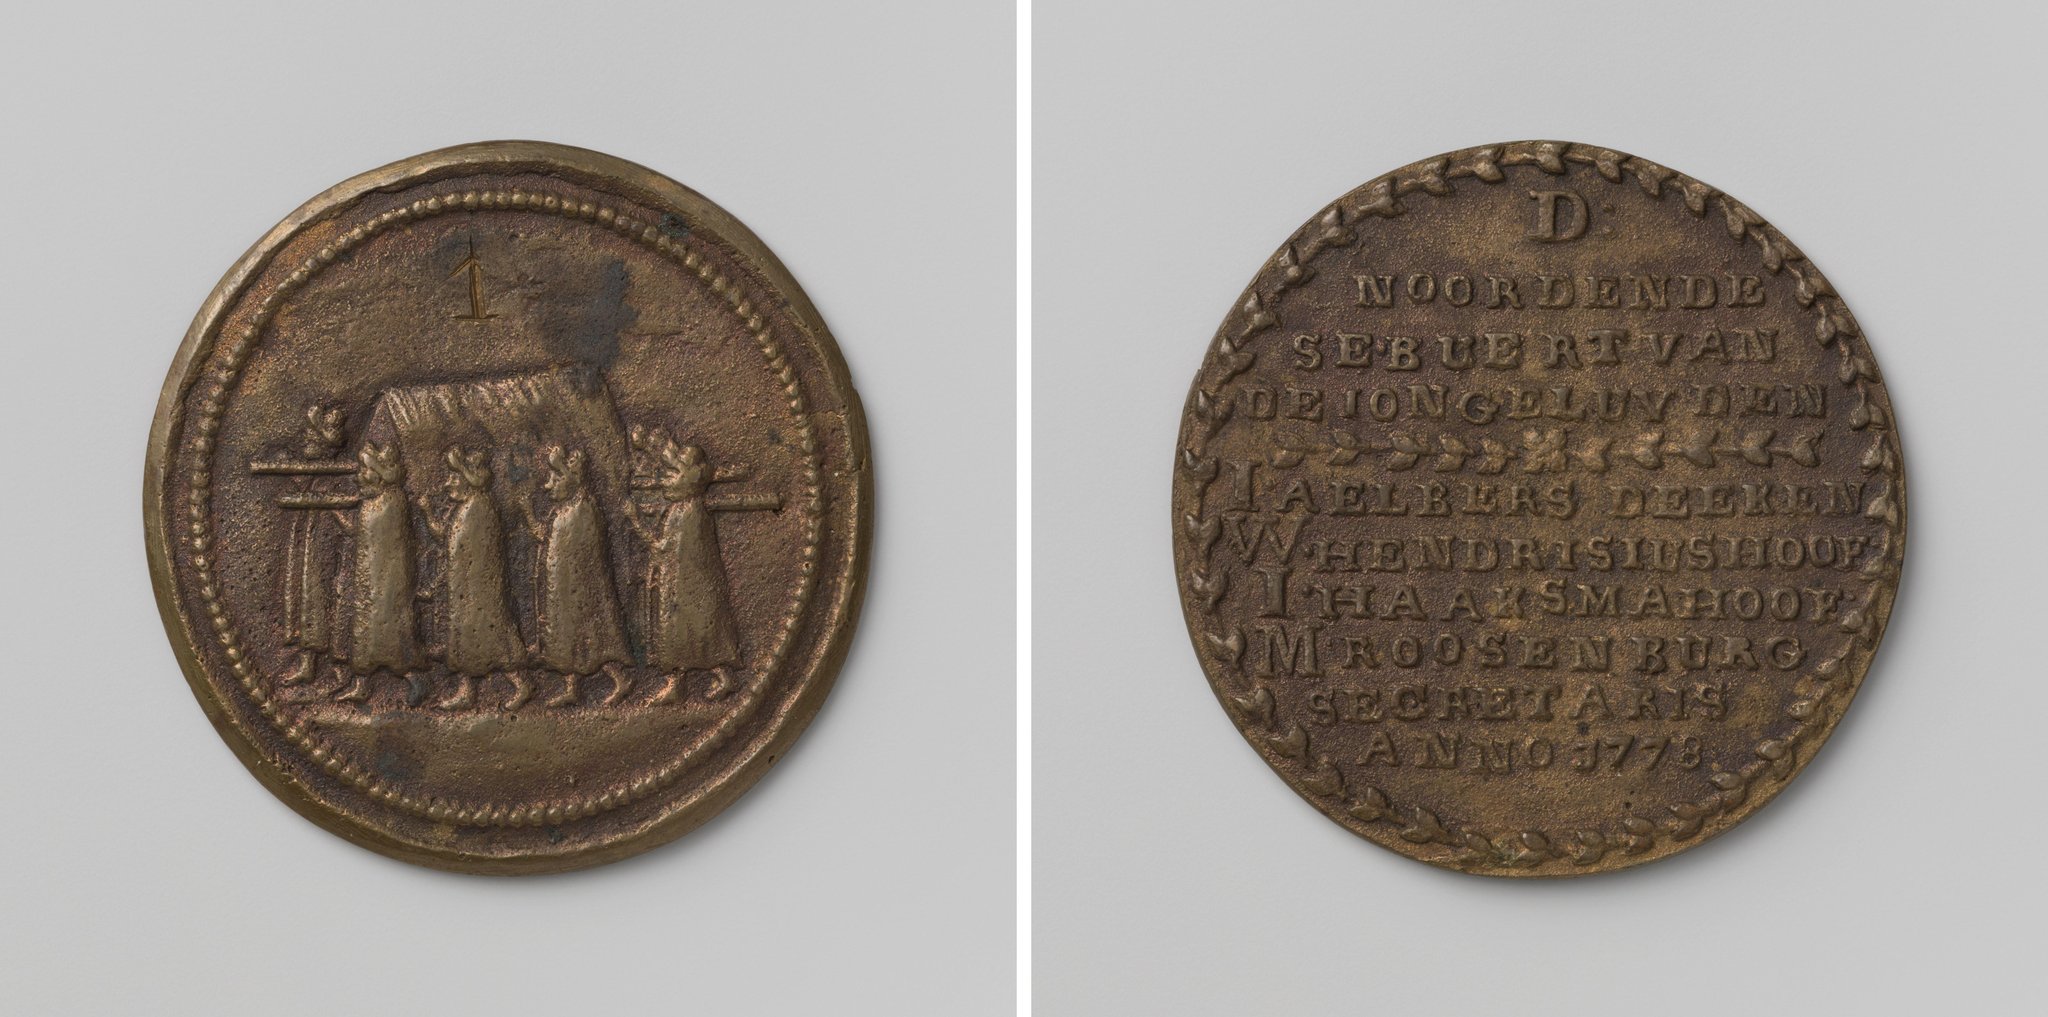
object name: funeral token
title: Buurt Noordeinde te 's-Gravenhage, begrafenispenning van de jongeluyden met no. 1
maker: Anonymous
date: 1778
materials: brass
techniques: casting, engraving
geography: the hague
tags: i. aelbers, w. hendrisius, i. haaksma, m. roosenburg, noordeinde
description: Messing penning. Voorzijde: zes mannen met lijkbaar onder cijfer 1 binnen parelrand. Keerzijde: opschrift binnen bladerkrans